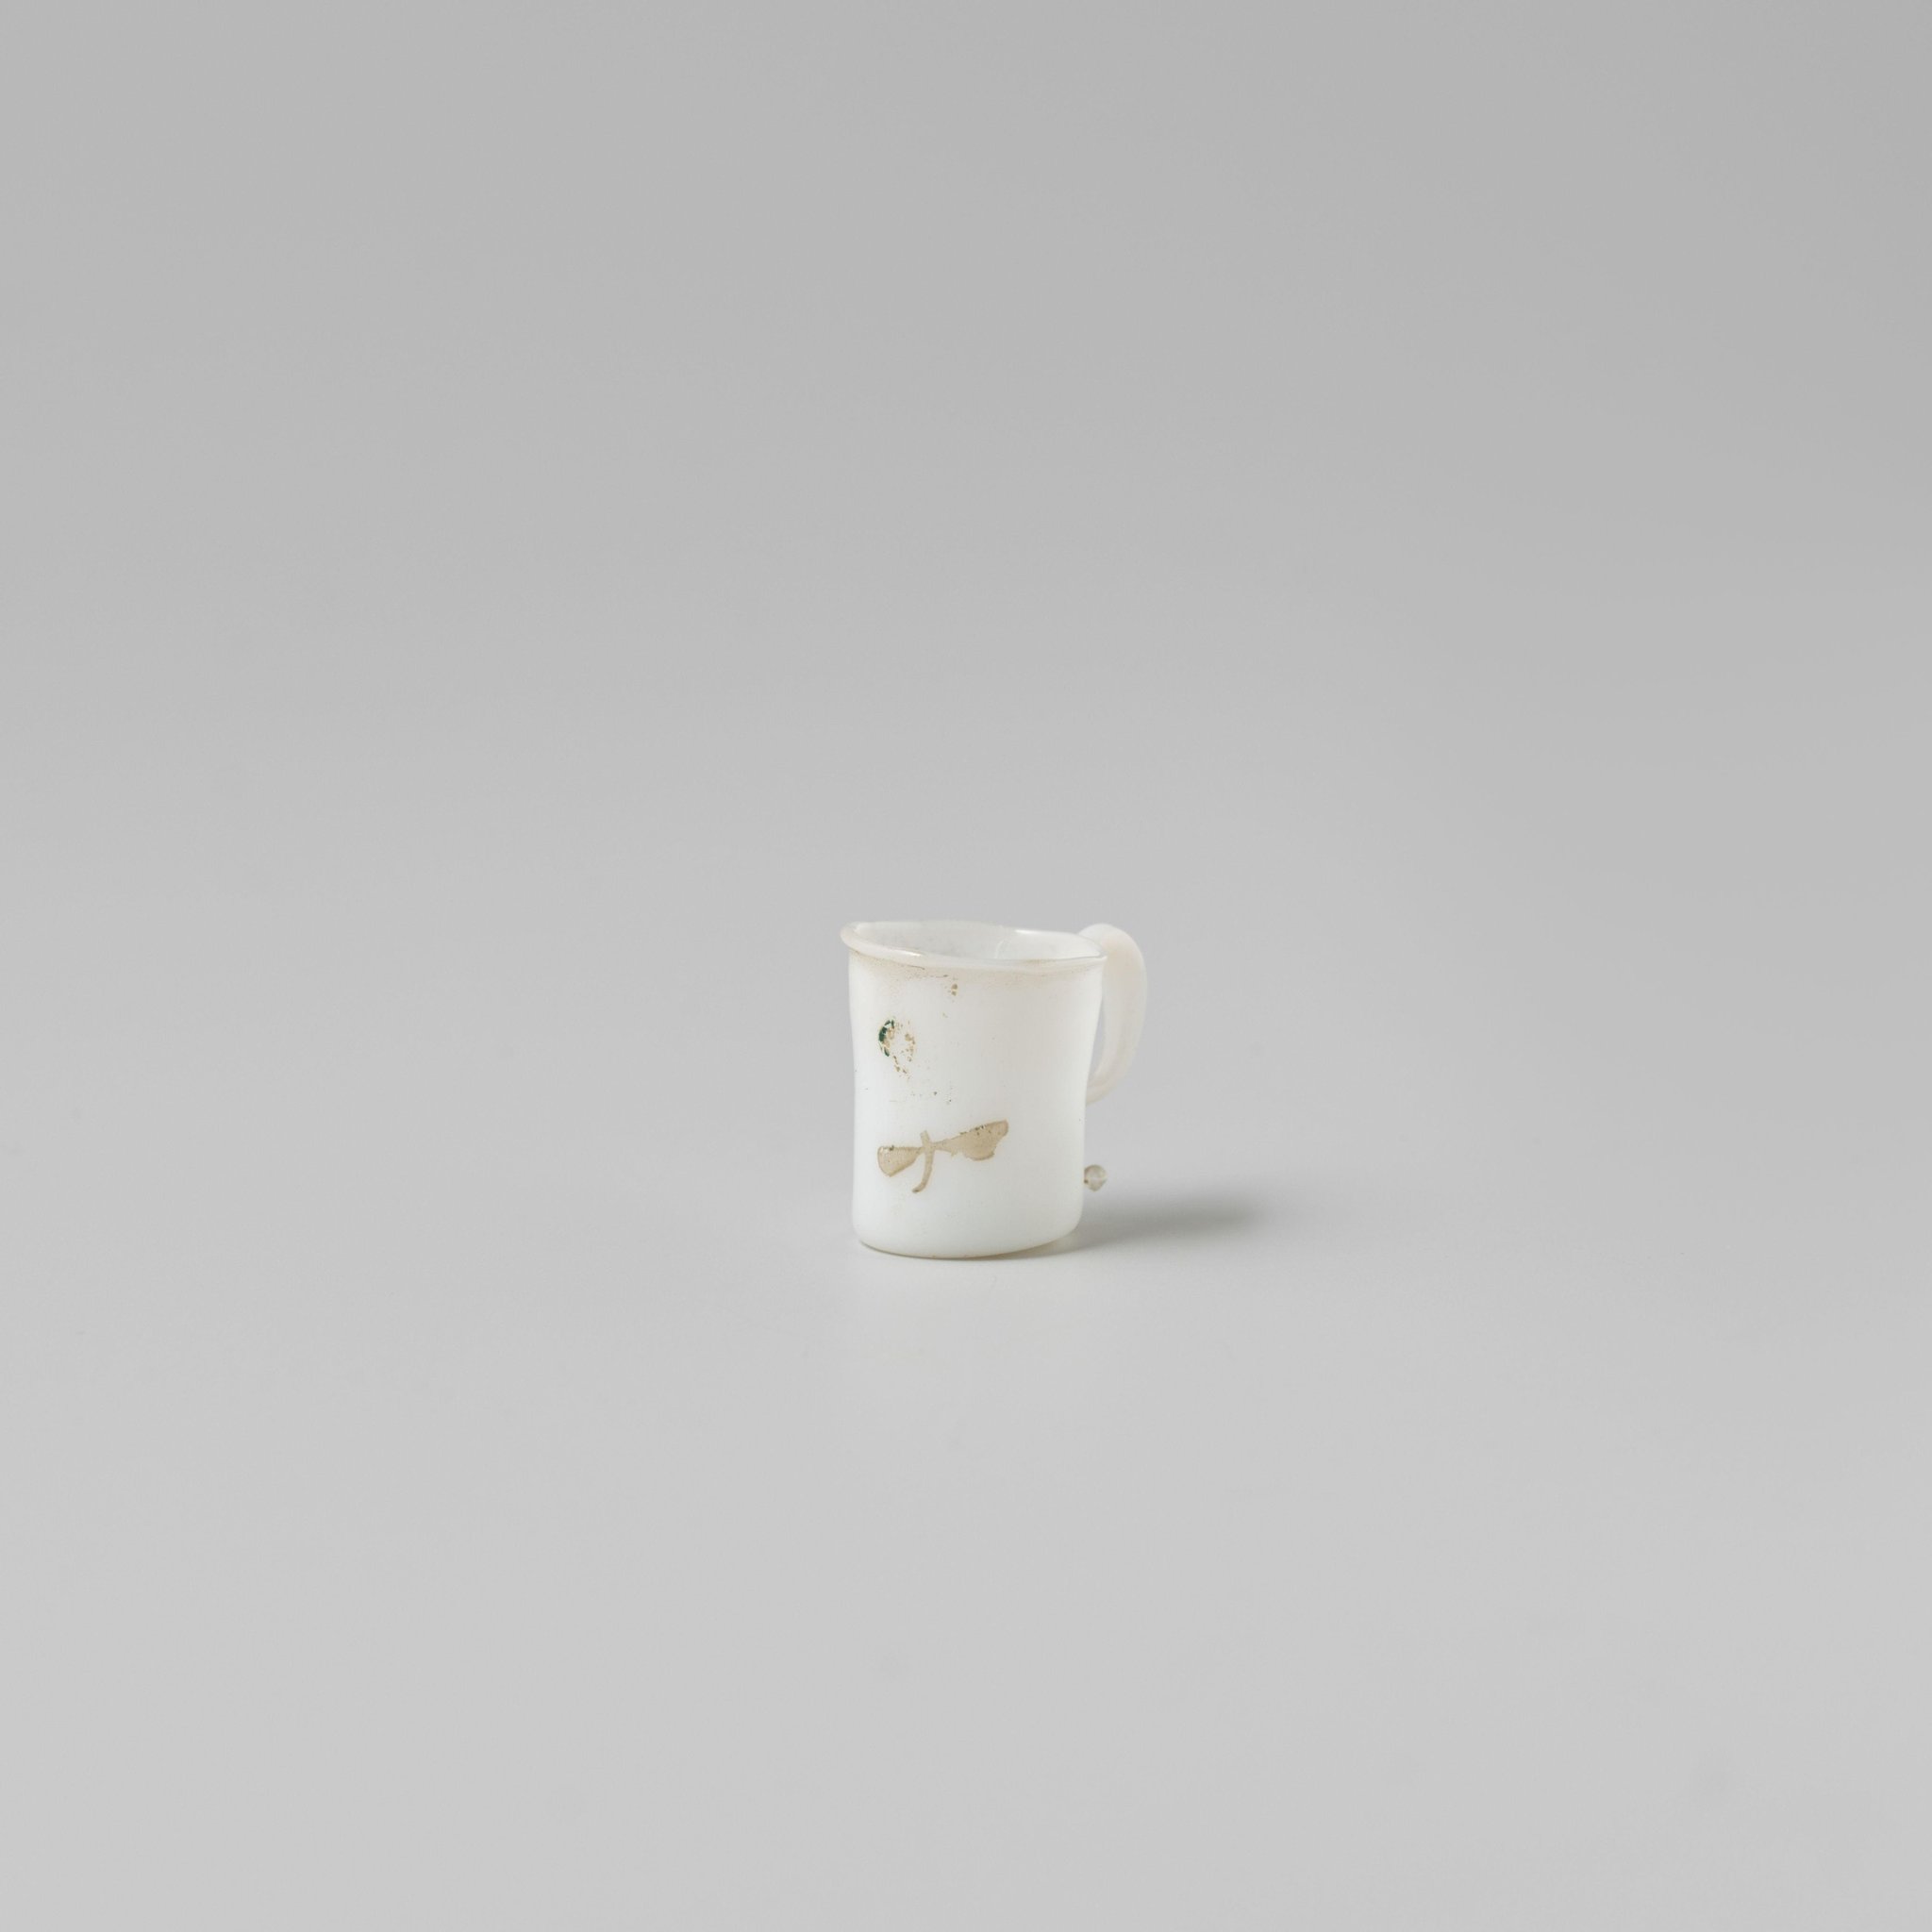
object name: miniature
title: Kop met oor, beschilderd met bloem in wit, rood en groen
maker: Anonymous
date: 1800-1849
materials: glass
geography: bristol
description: Kop van opaak wit glas, cilindrisch, met s-vormig oor. De kop is beschilderd met een bloem in wit, rood en groen.